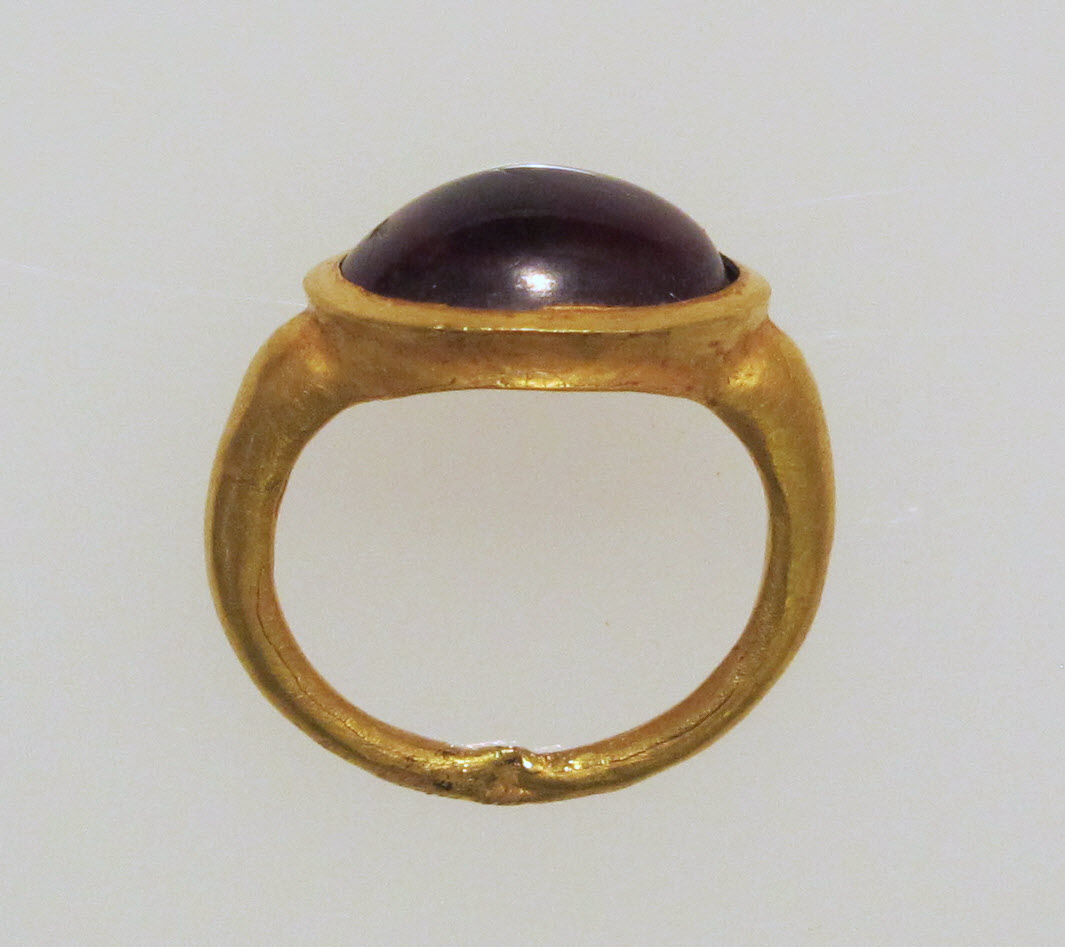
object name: ring with garnet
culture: roman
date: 100 BCE-100 CE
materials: gold